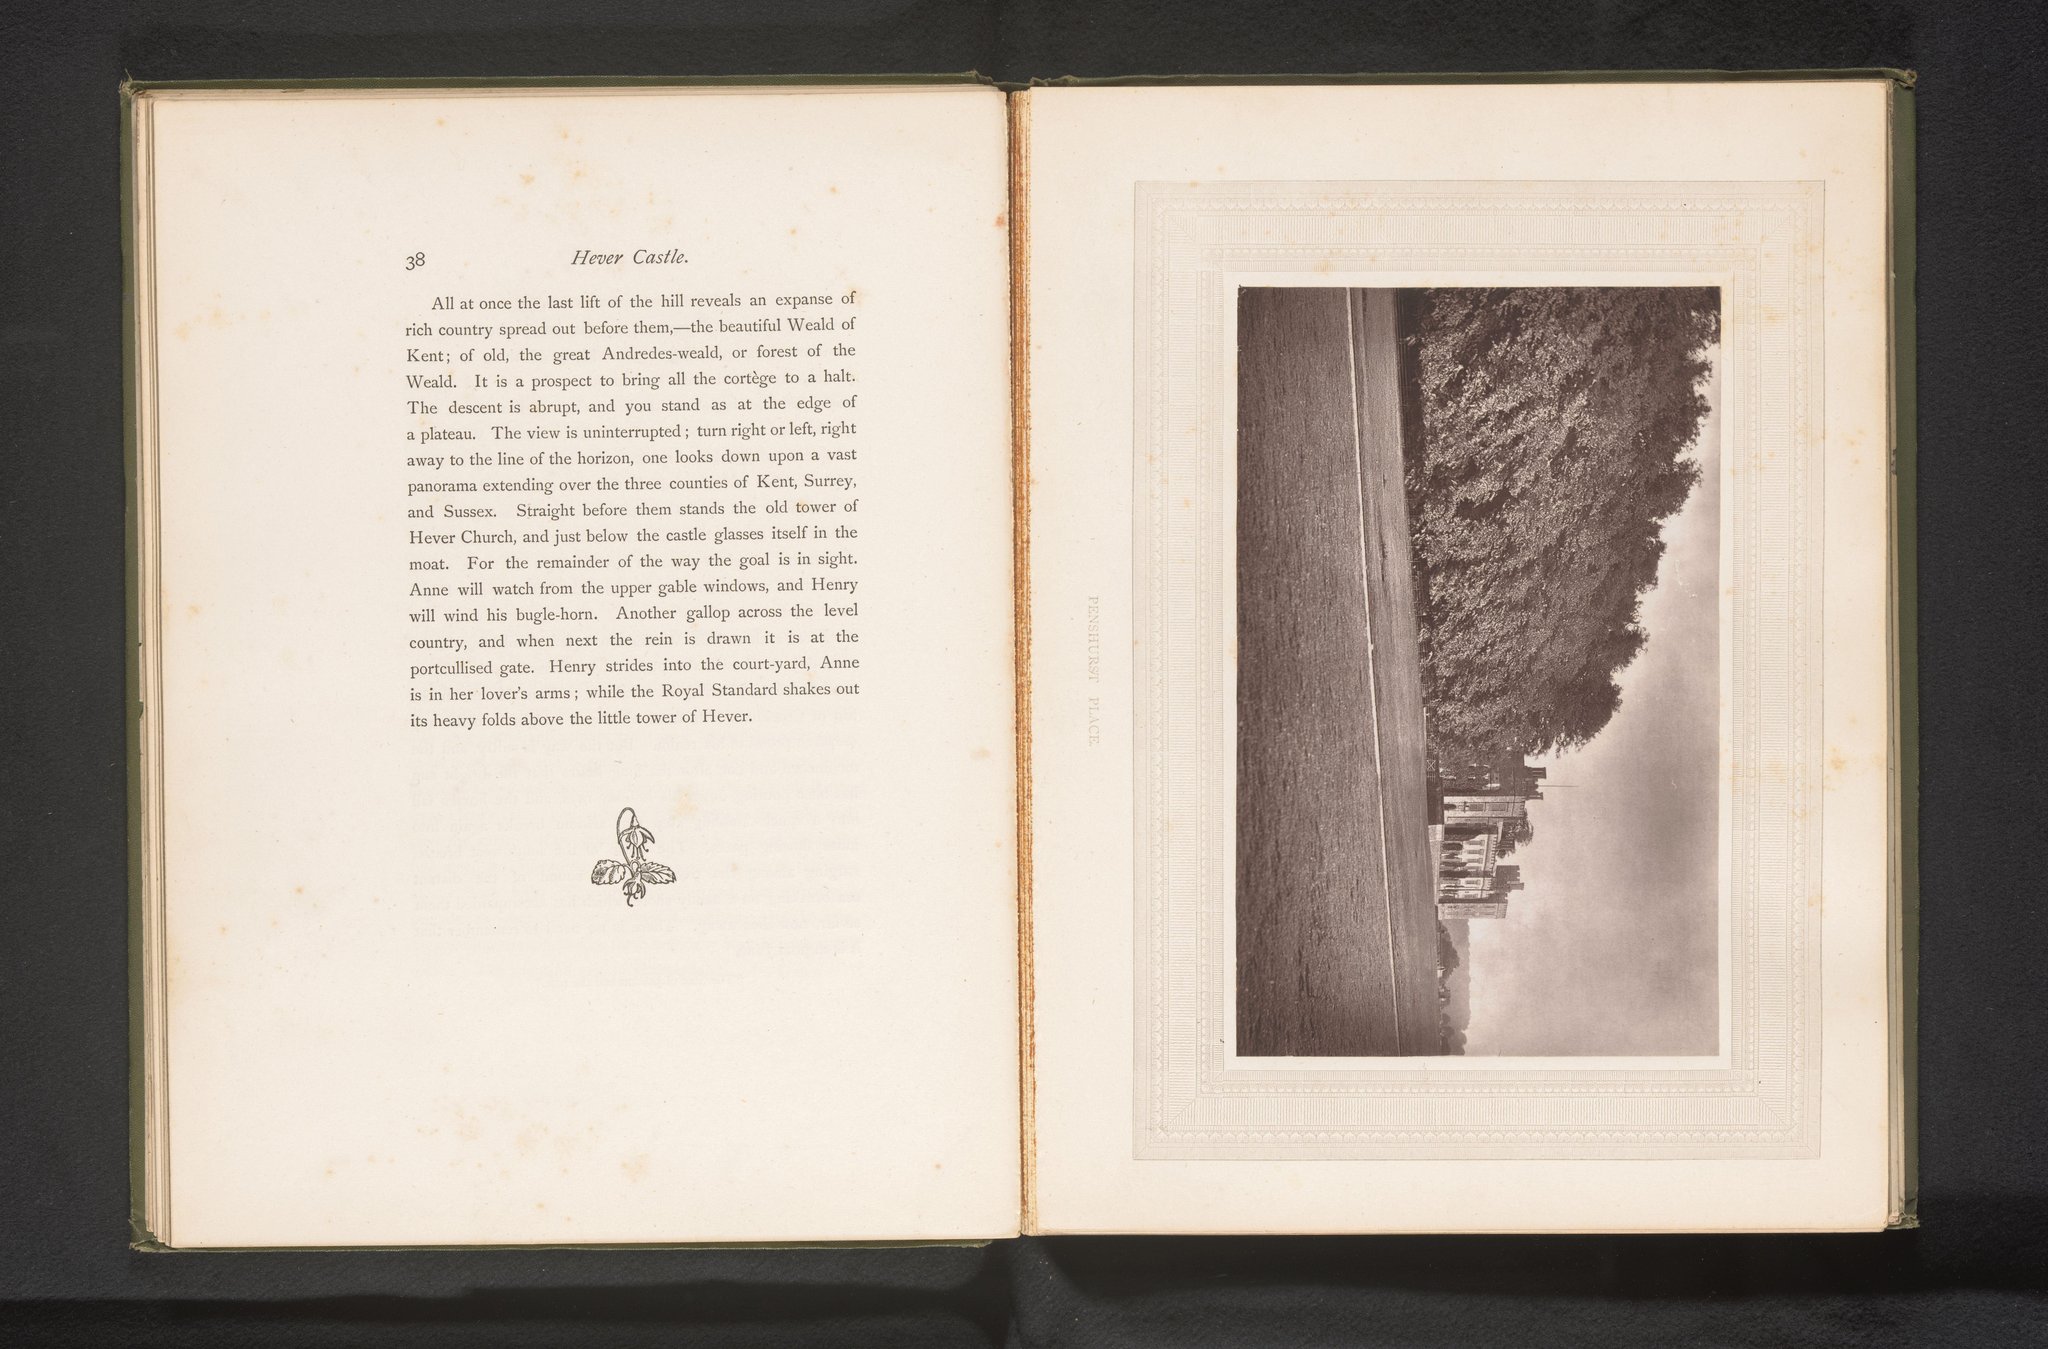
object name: page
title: Gezicht op Penshurst Place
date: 1866-1876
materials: paper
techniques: woodburytype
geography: penshurst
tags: rural housing, e.g. country-house, villa, cottage